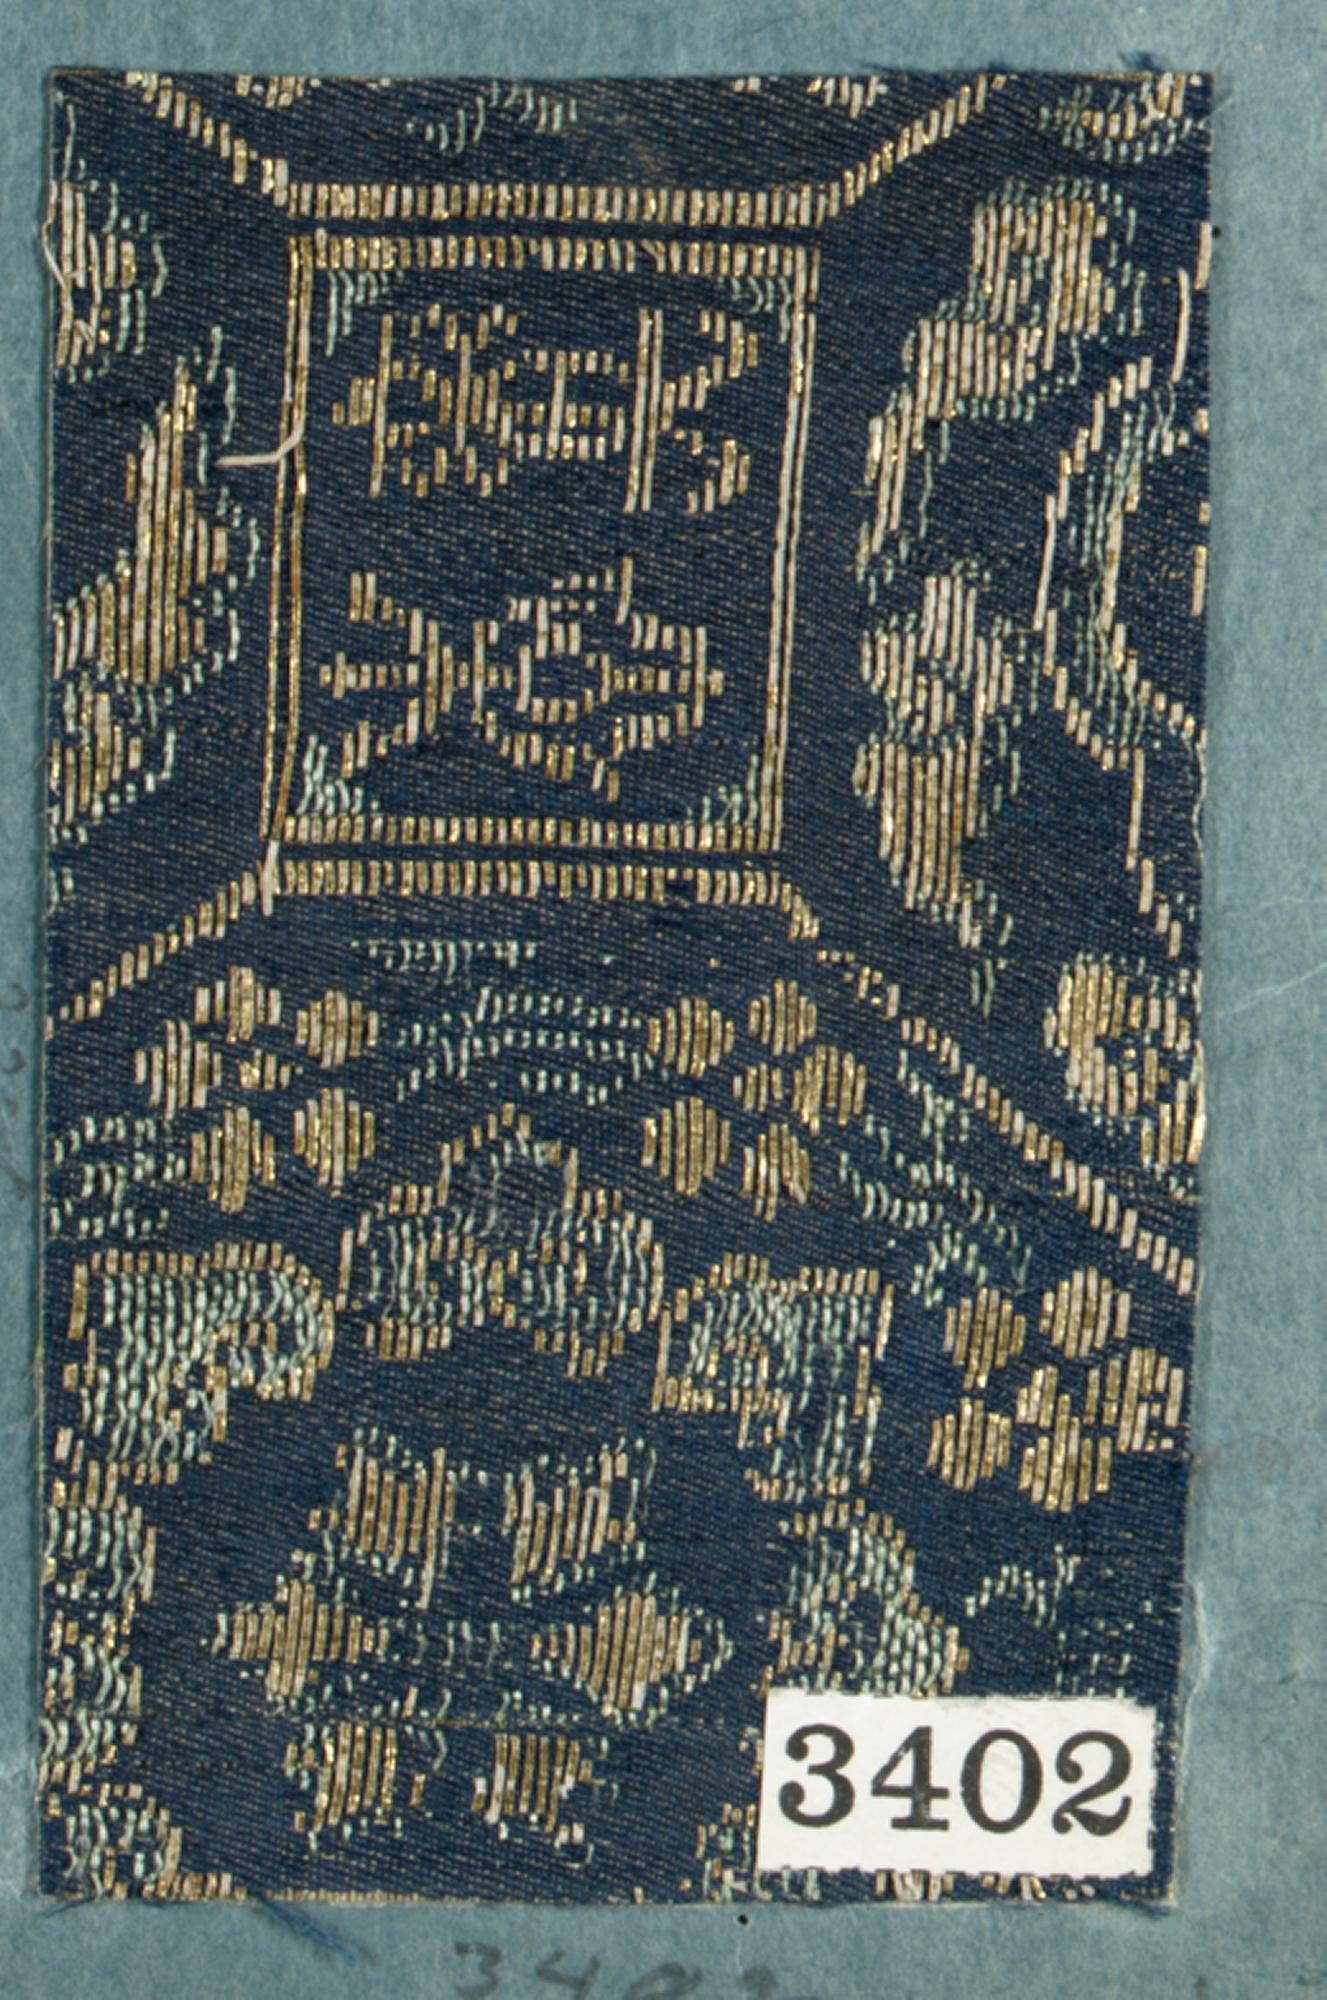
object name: textile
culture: japanese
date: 1801-1900